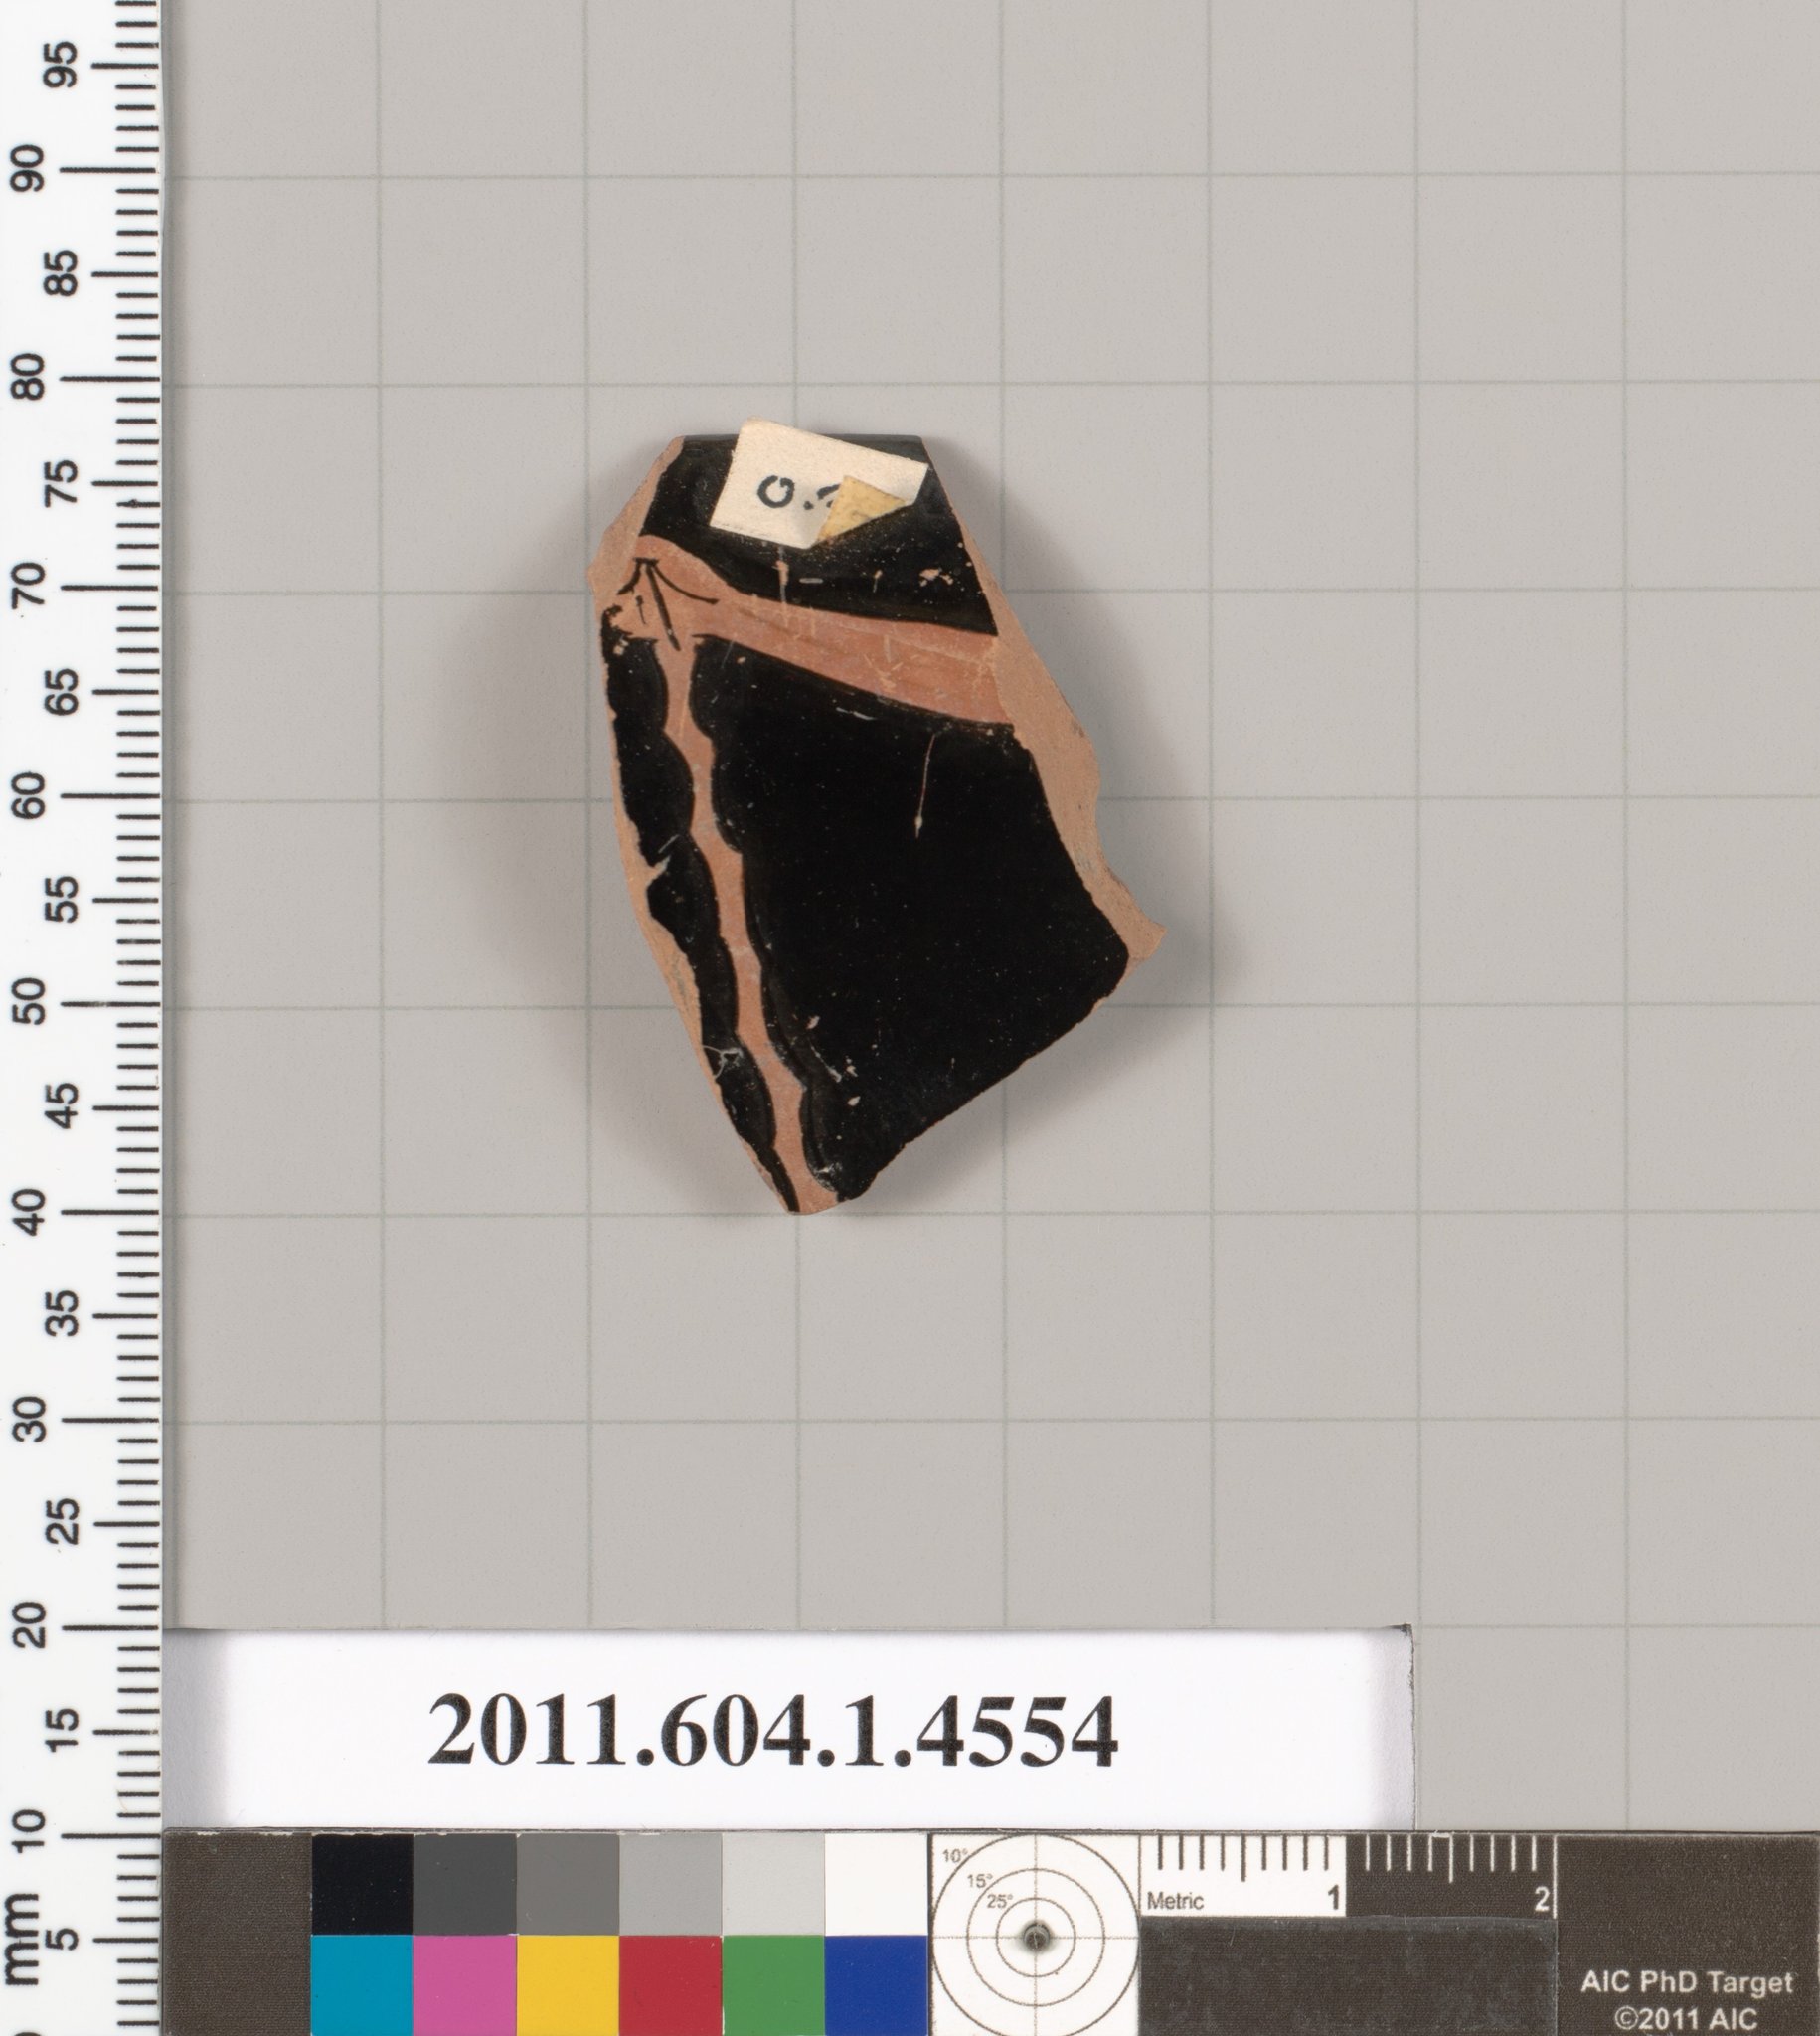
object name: kylix fragment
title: Terracotta fragment of a kylix (drinking cup)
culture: greek, attic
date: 500-480 BCE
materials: terracotta